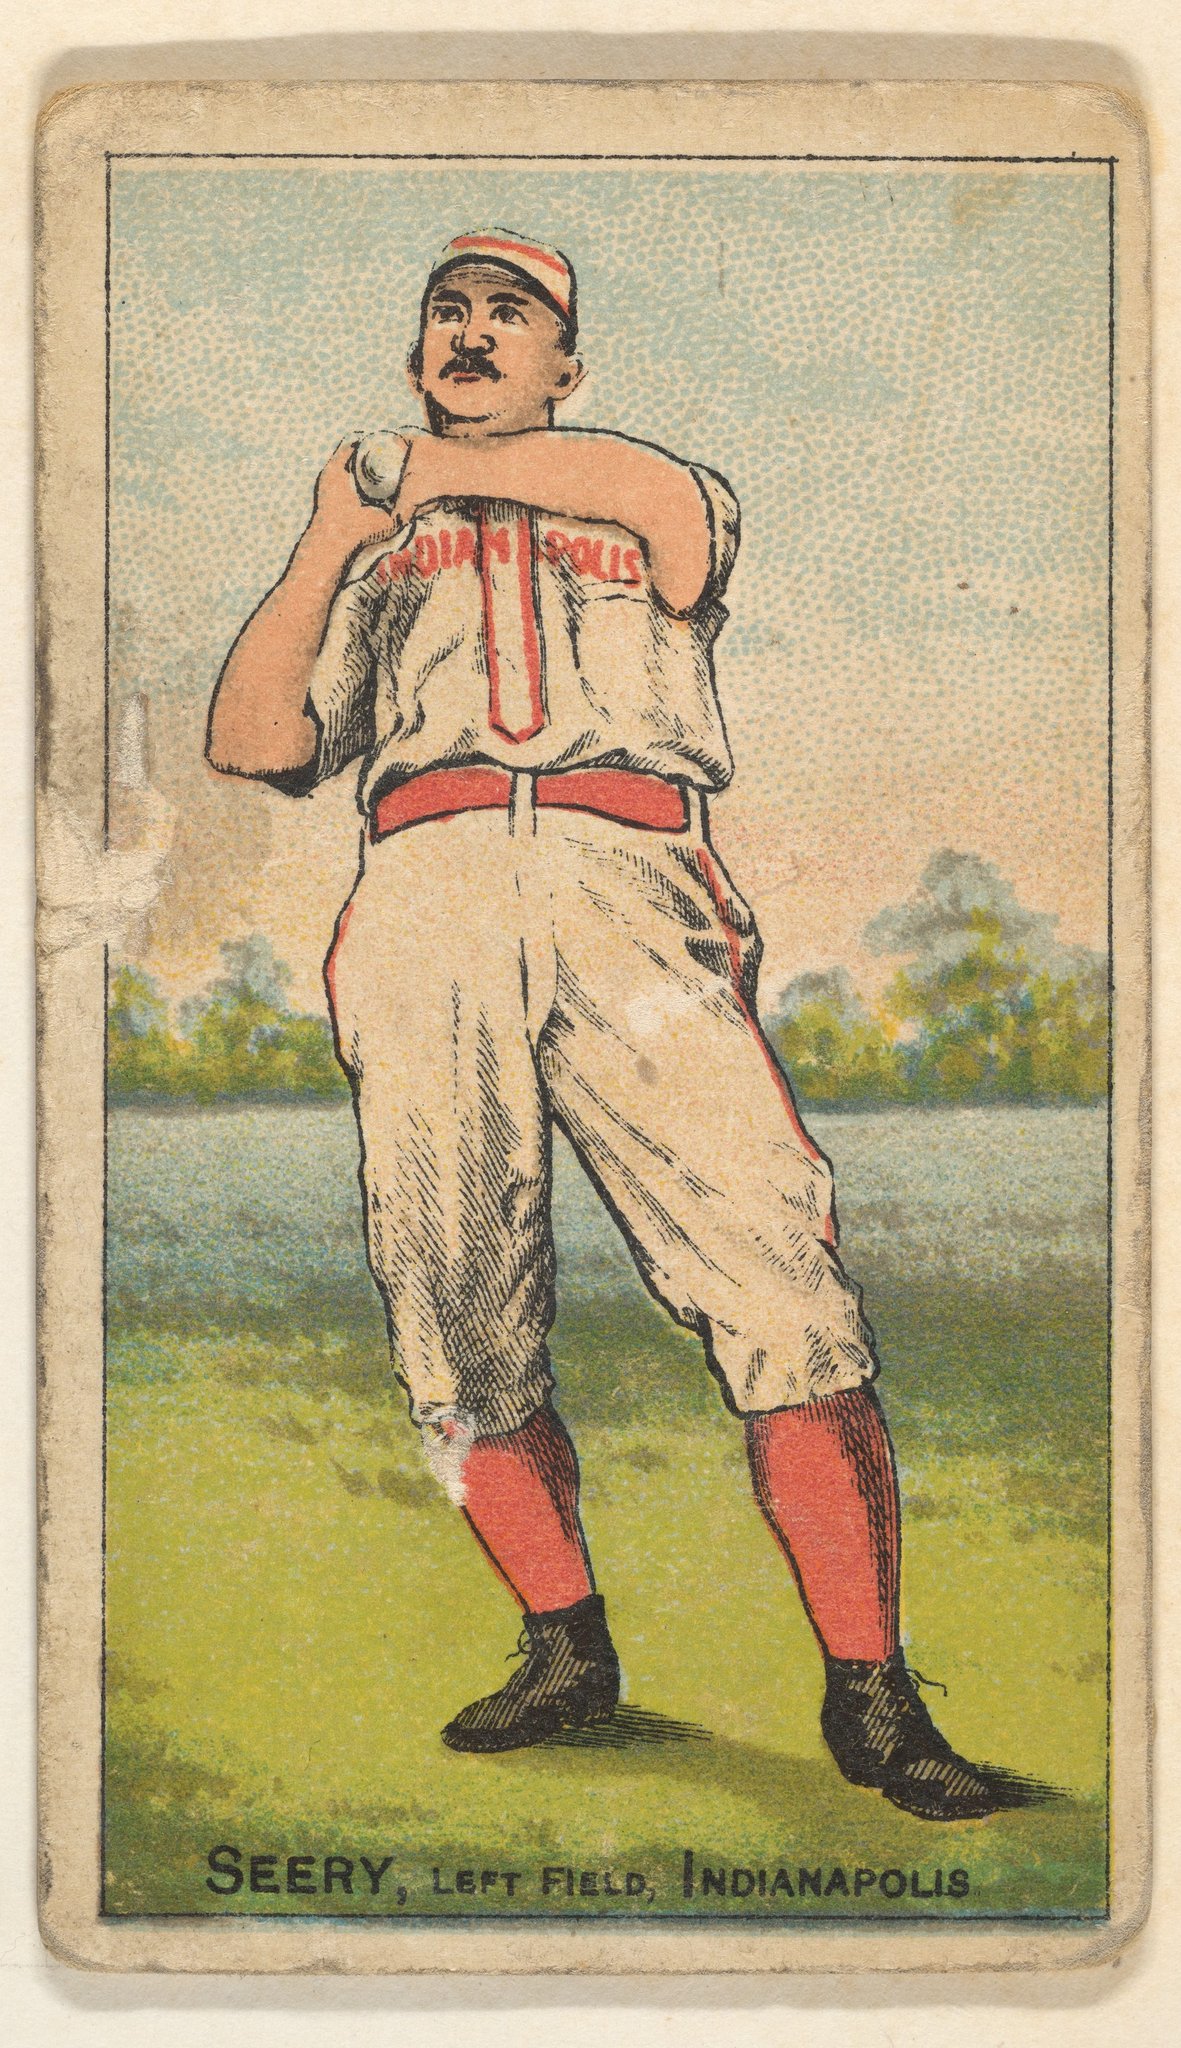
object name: baseball card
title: Seery (Hands At Right Shoulder), Left Field, Indianapolis, from the Gold Coin series (N284) for Gold Coin Chewing Tobacco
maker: d. buchner & co., new york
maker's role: publisher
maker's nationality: american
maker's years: 1850-1900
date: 1887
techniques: color lithograph, drawing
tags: men,baseball,athletes